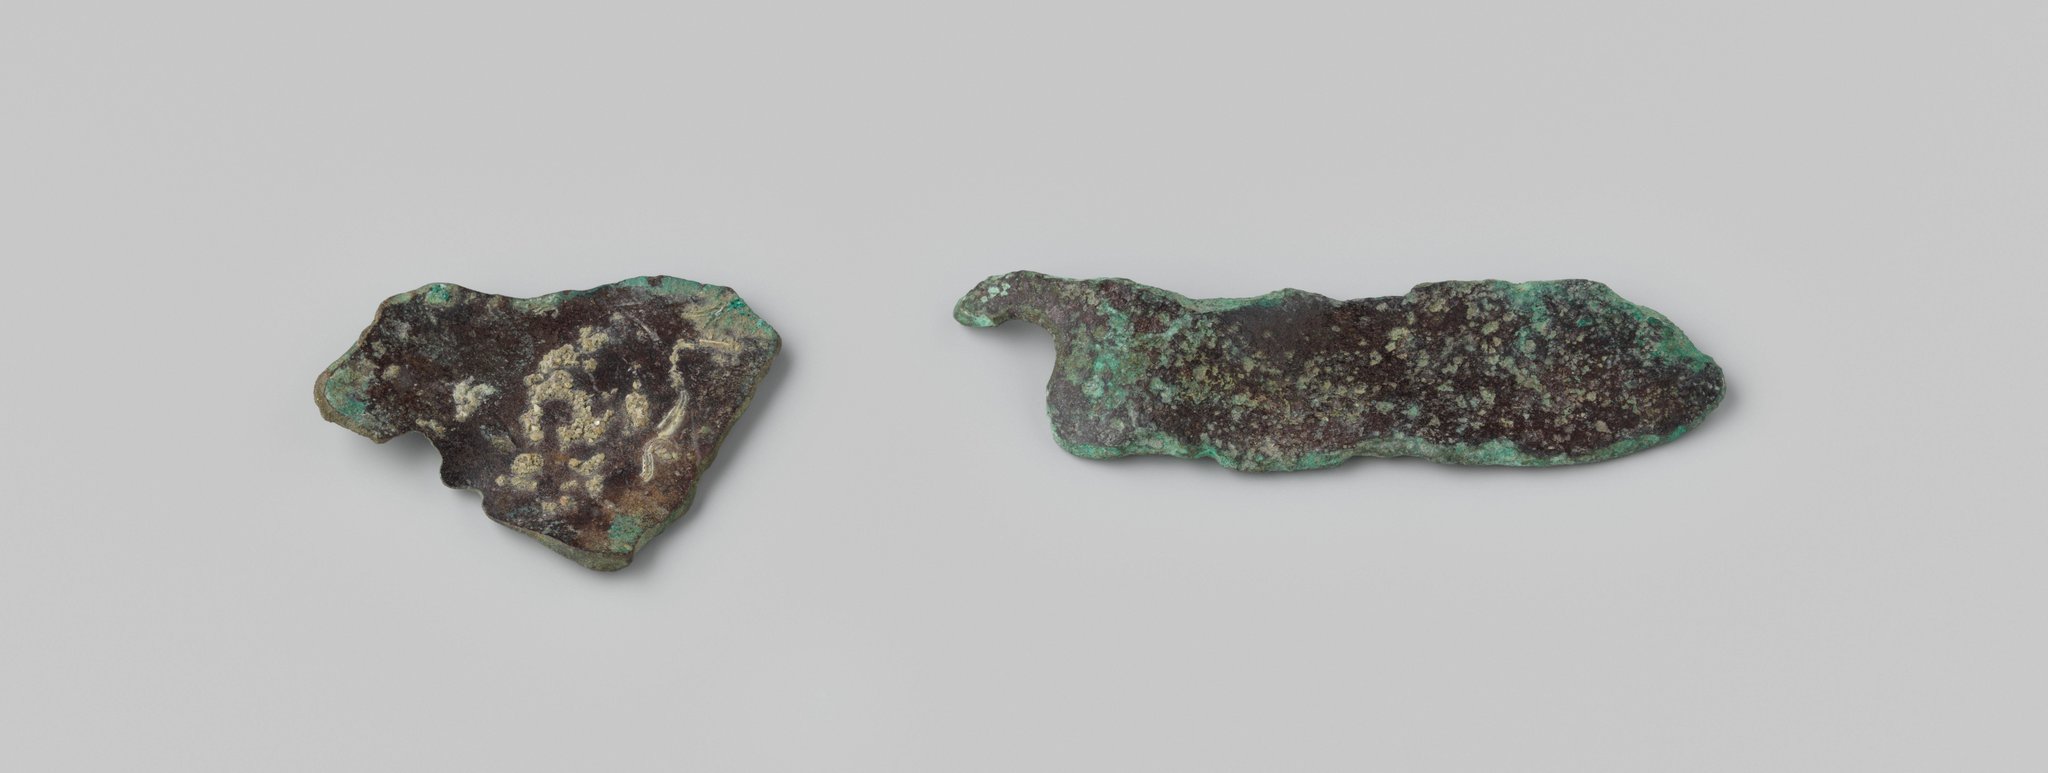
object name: part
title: Onderdeel of hulpstuk afkomstig uit het wrak van de Oost-Indiëvaarder Hollandia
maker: Anonymous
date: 1700-1743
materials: copper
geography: netherlands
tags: verenigde oostindische compagnie, hollandia (schip)